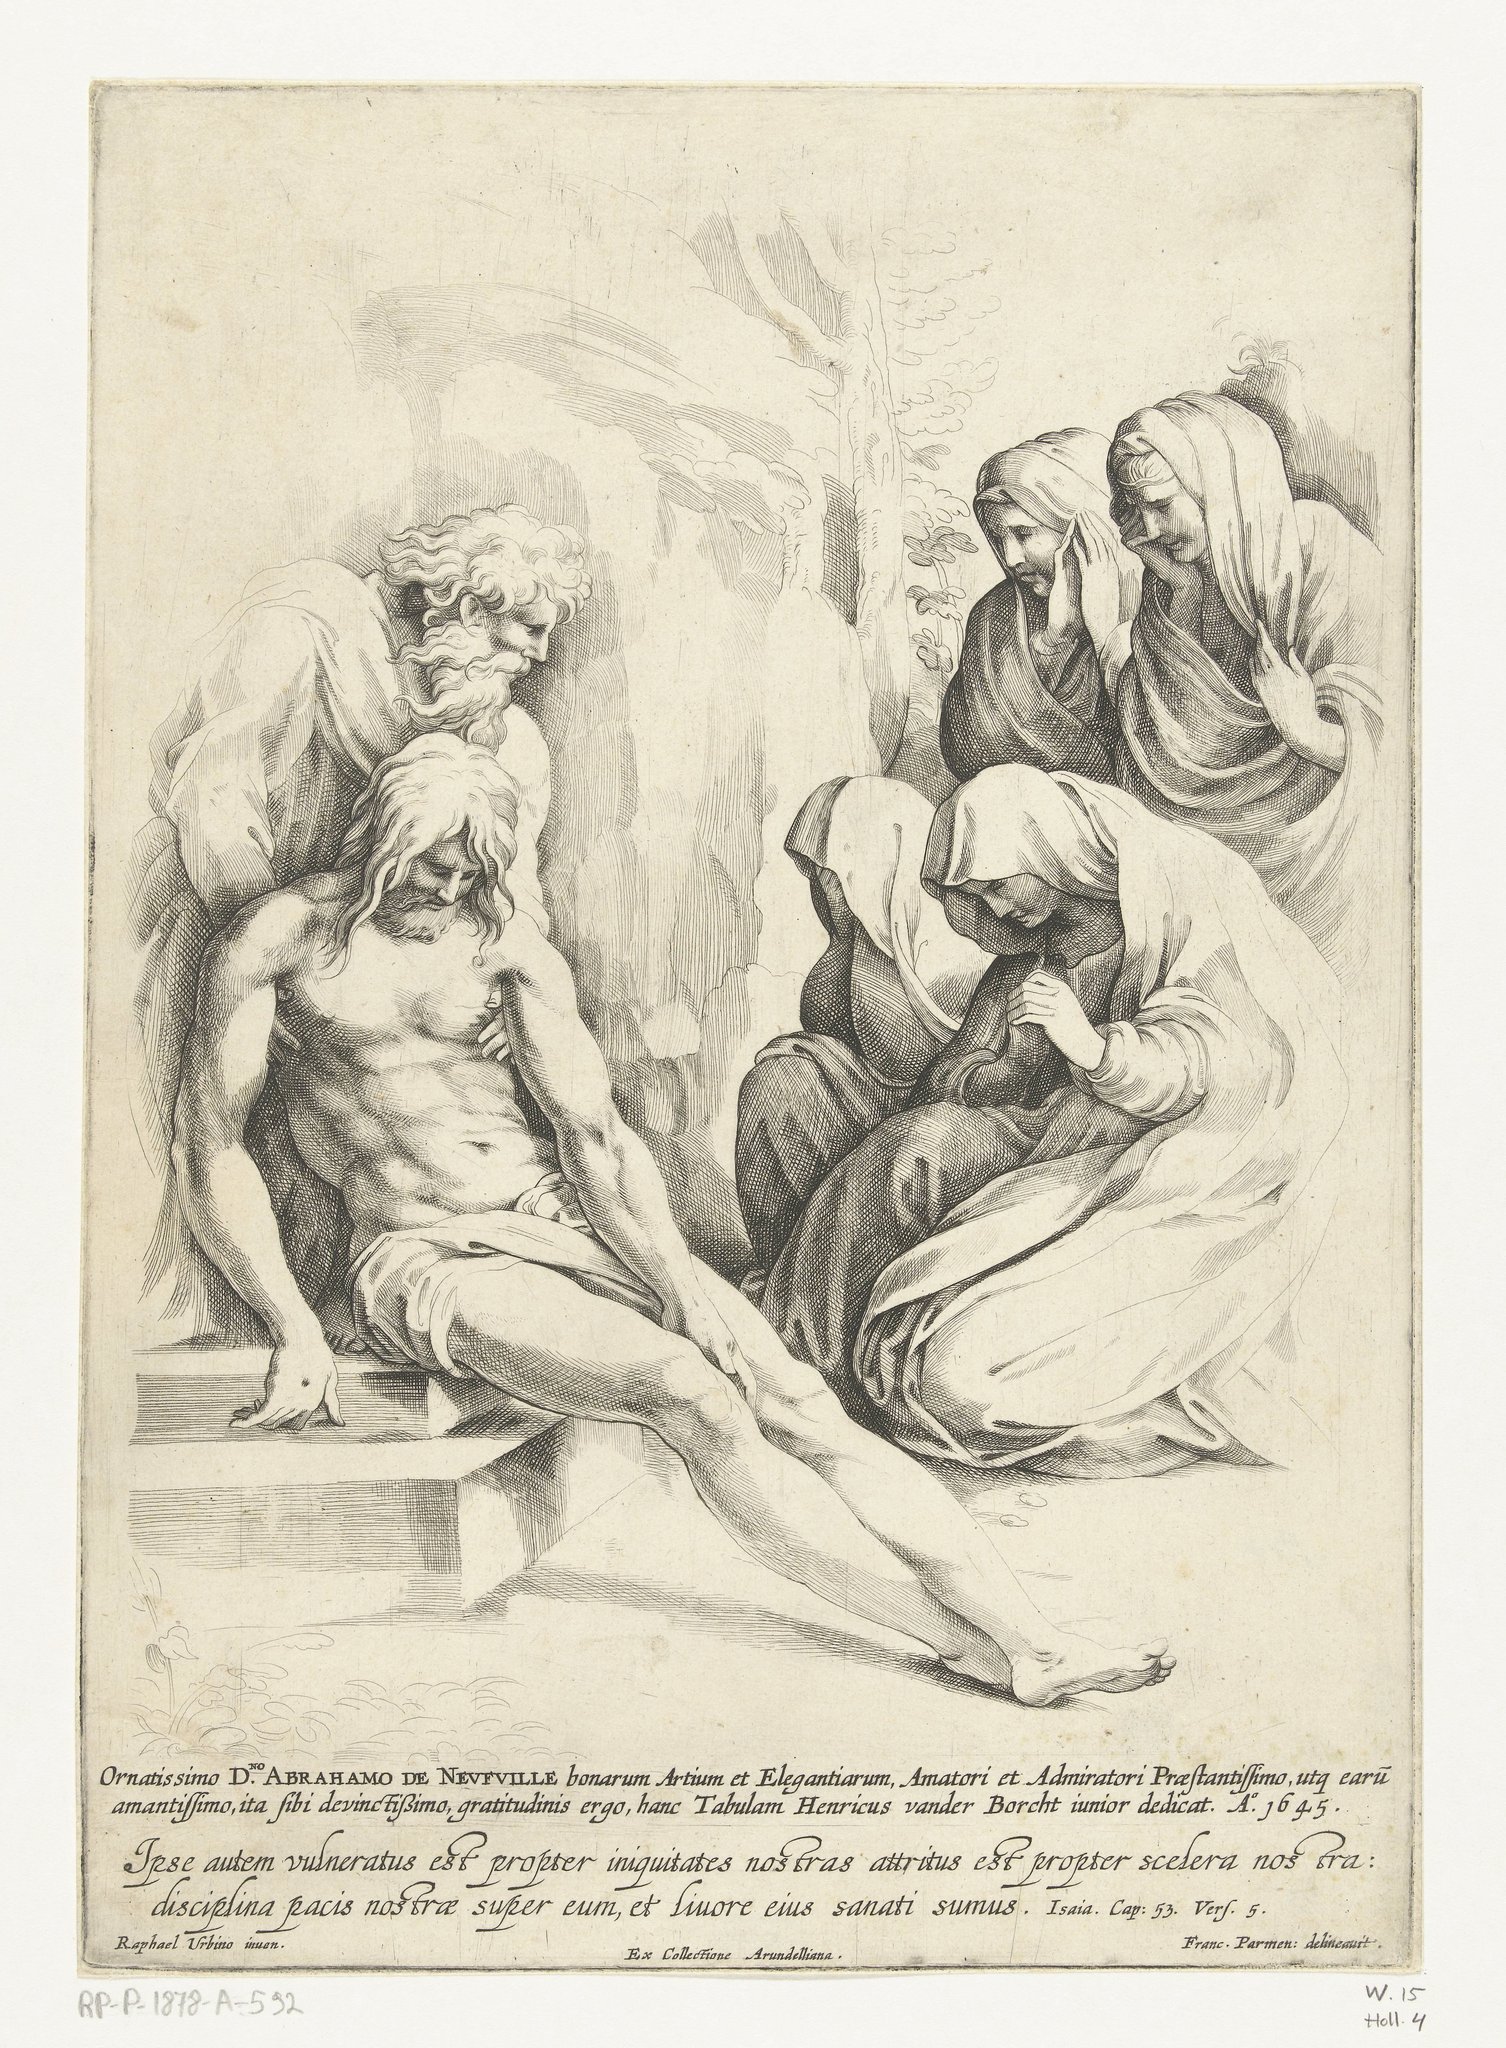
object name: print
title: Graflegging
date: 1645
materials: paper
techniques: engraving, etching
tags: christ's entombment (possibly by angels), bearing of christ's body to the grave, christ's body on or in the grave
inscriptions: collector's mark: Lugt 2228, name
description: Christus wordt door Jozef van Arimatea in het rotsgraf gelegd. Aan de rechterkant een groep treurende vrouwen waaronder Maria en Maria Magdelena. (Matteüs 27:57-61). De prent heet twee Latijnse onderschriften.